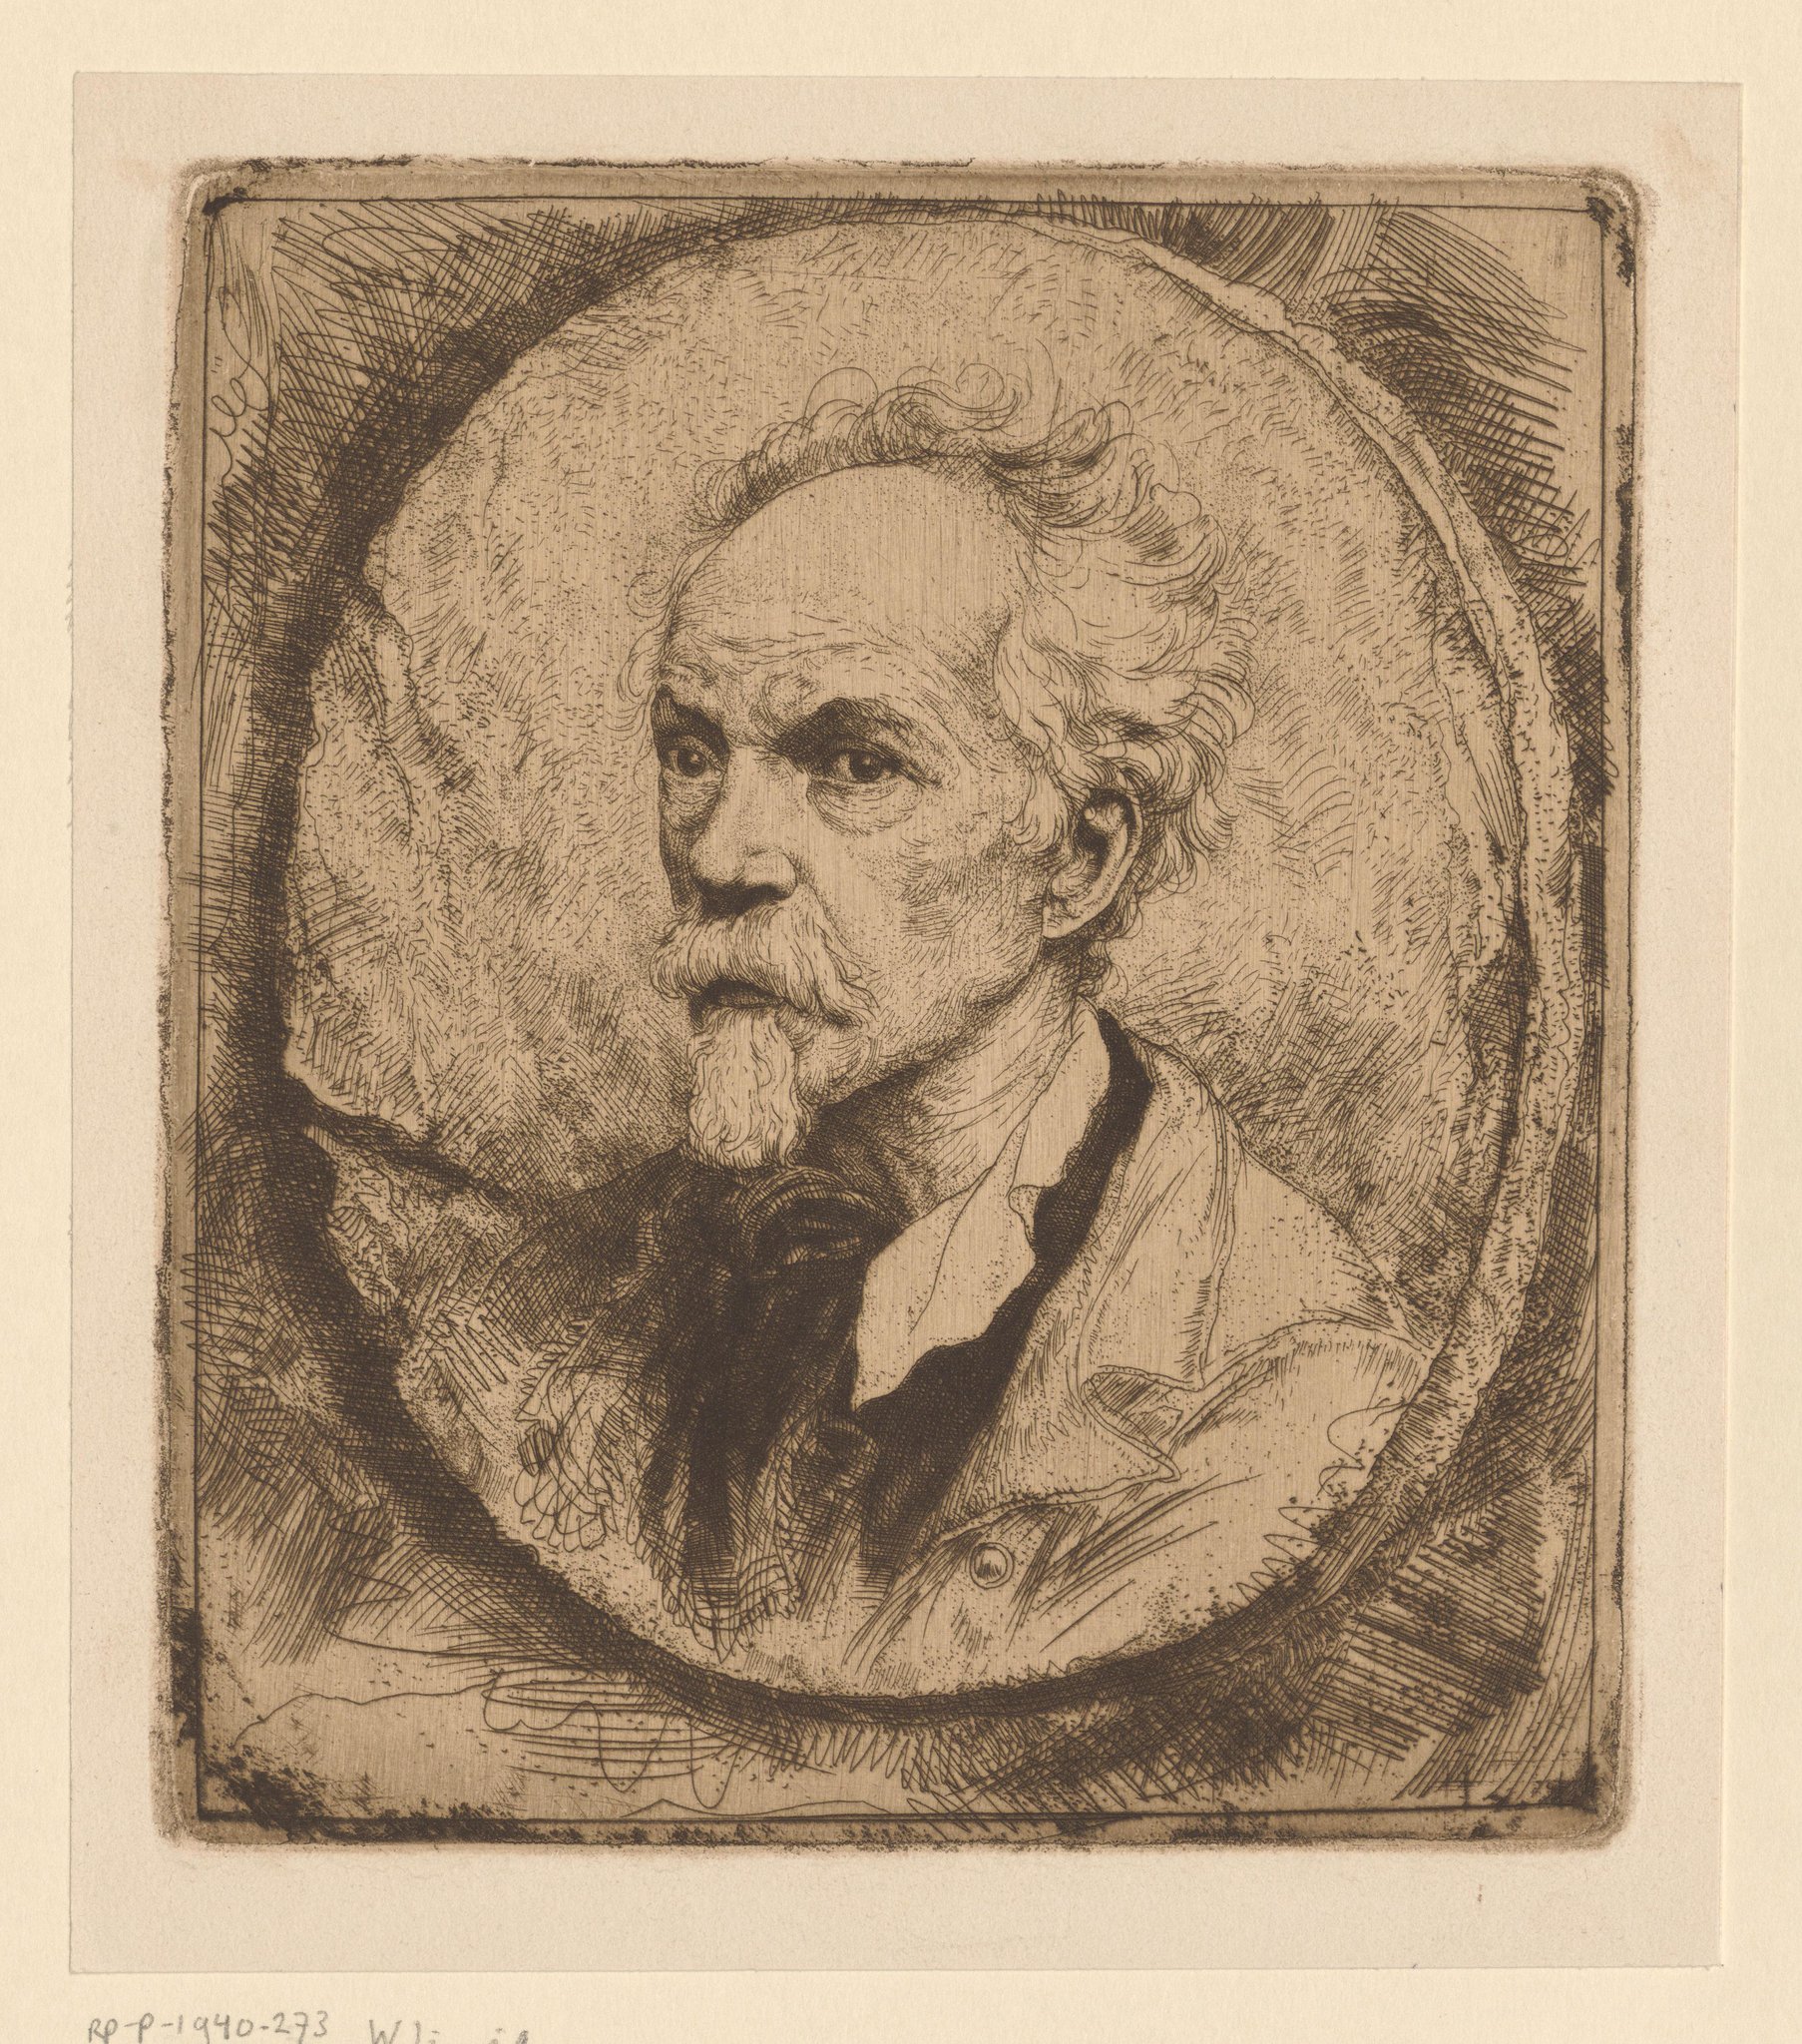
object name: print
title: Portret van Jean Théodore Joseph Linnig, mogelijk zelfportret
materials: paper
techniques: etching, intaglio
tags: antwerp, draughtsman, jean théodore joseph linnig, historical persons, portrait, self-portrait of artist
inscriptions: inscription: ‘J Linnig aan zijnen vriend P. van der Kellen/ Antwerpen 21-8.1889.’, collector's mark: Lugt 2760, collector's mark: Lugt 2228, inscription: ‘Jan Theodoor Joseph Linnig/ W. Linnig jr sc.’